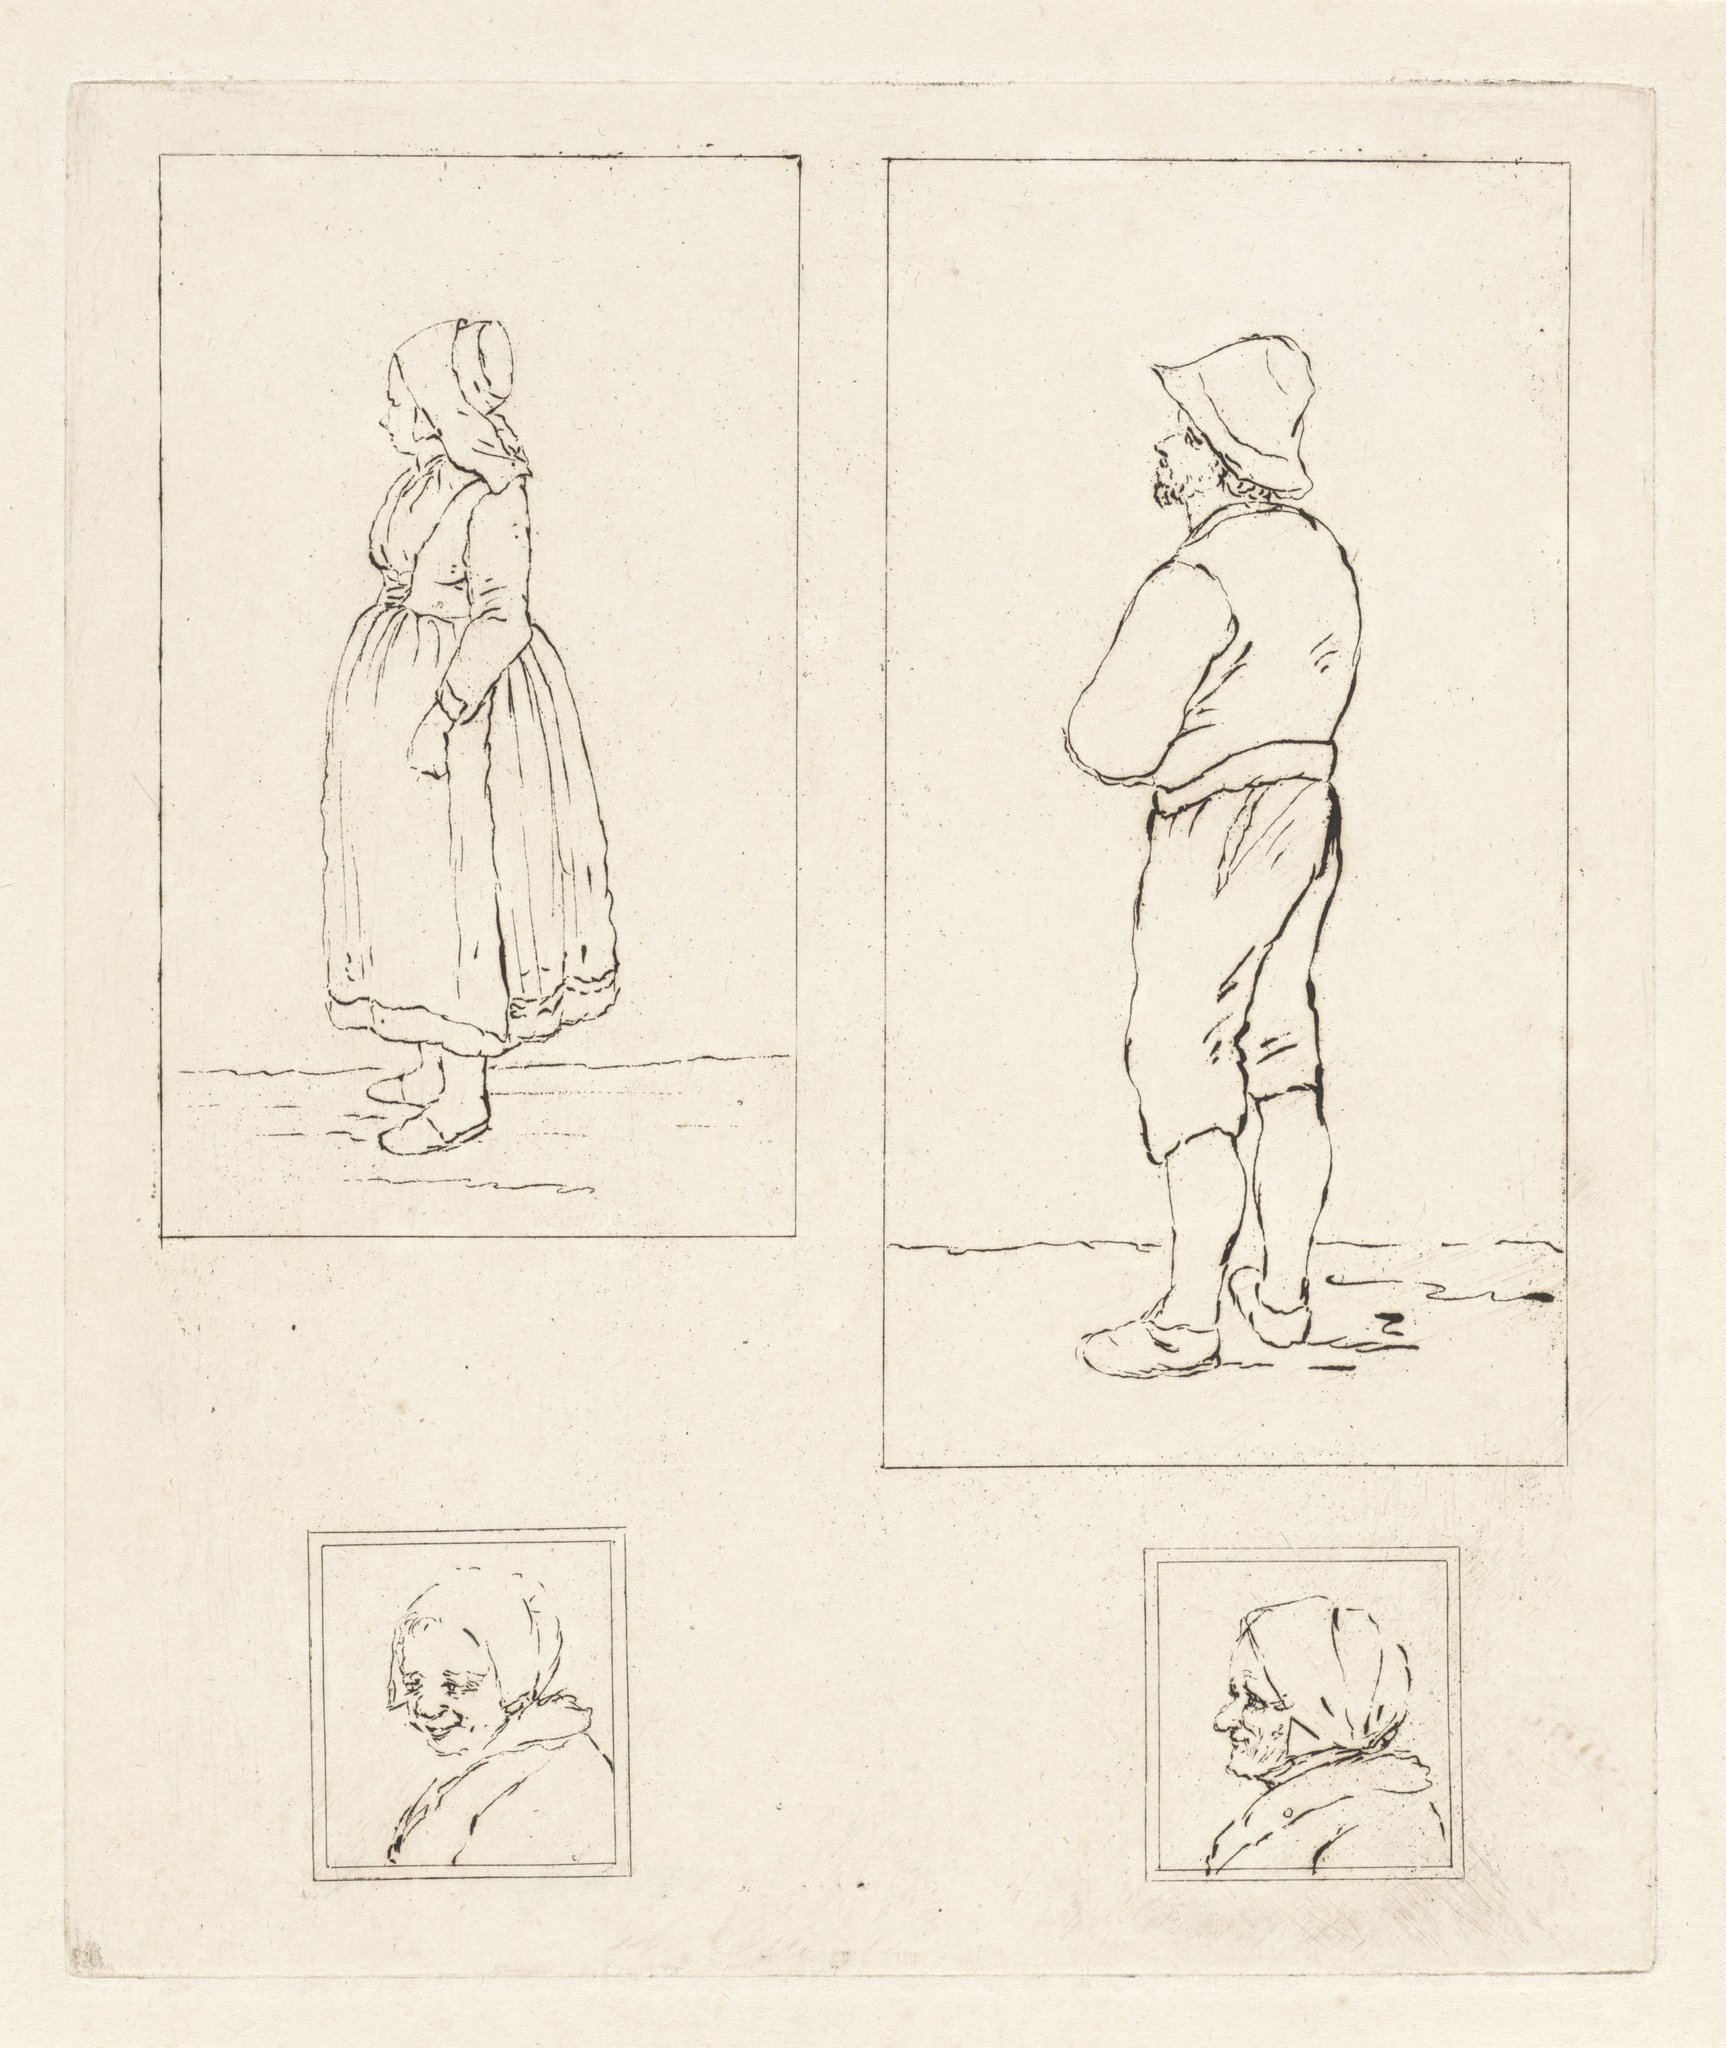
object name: print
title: Vier figuurstudies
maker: nicolaas van der worm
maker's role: draughtsman, print maker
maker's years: 1757-1828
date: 1772-1828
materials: paper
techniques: etching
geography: leiden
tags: head (human) (+ three-quarter view), adult woman, head (human) (+ sideview, profile), adult man, old woman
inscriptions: collector's mark: Lugt 240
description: Vier figuurstudies in eenvoudige kaders. Linksboven een staande vrouw met een muts en profil. Rechtsboven een staande man. Links- en rechtsonder een studie van een hoofd van een oude vrouw met een muts, het linker hoofd driekwart weergegeven en het rechter en profil.